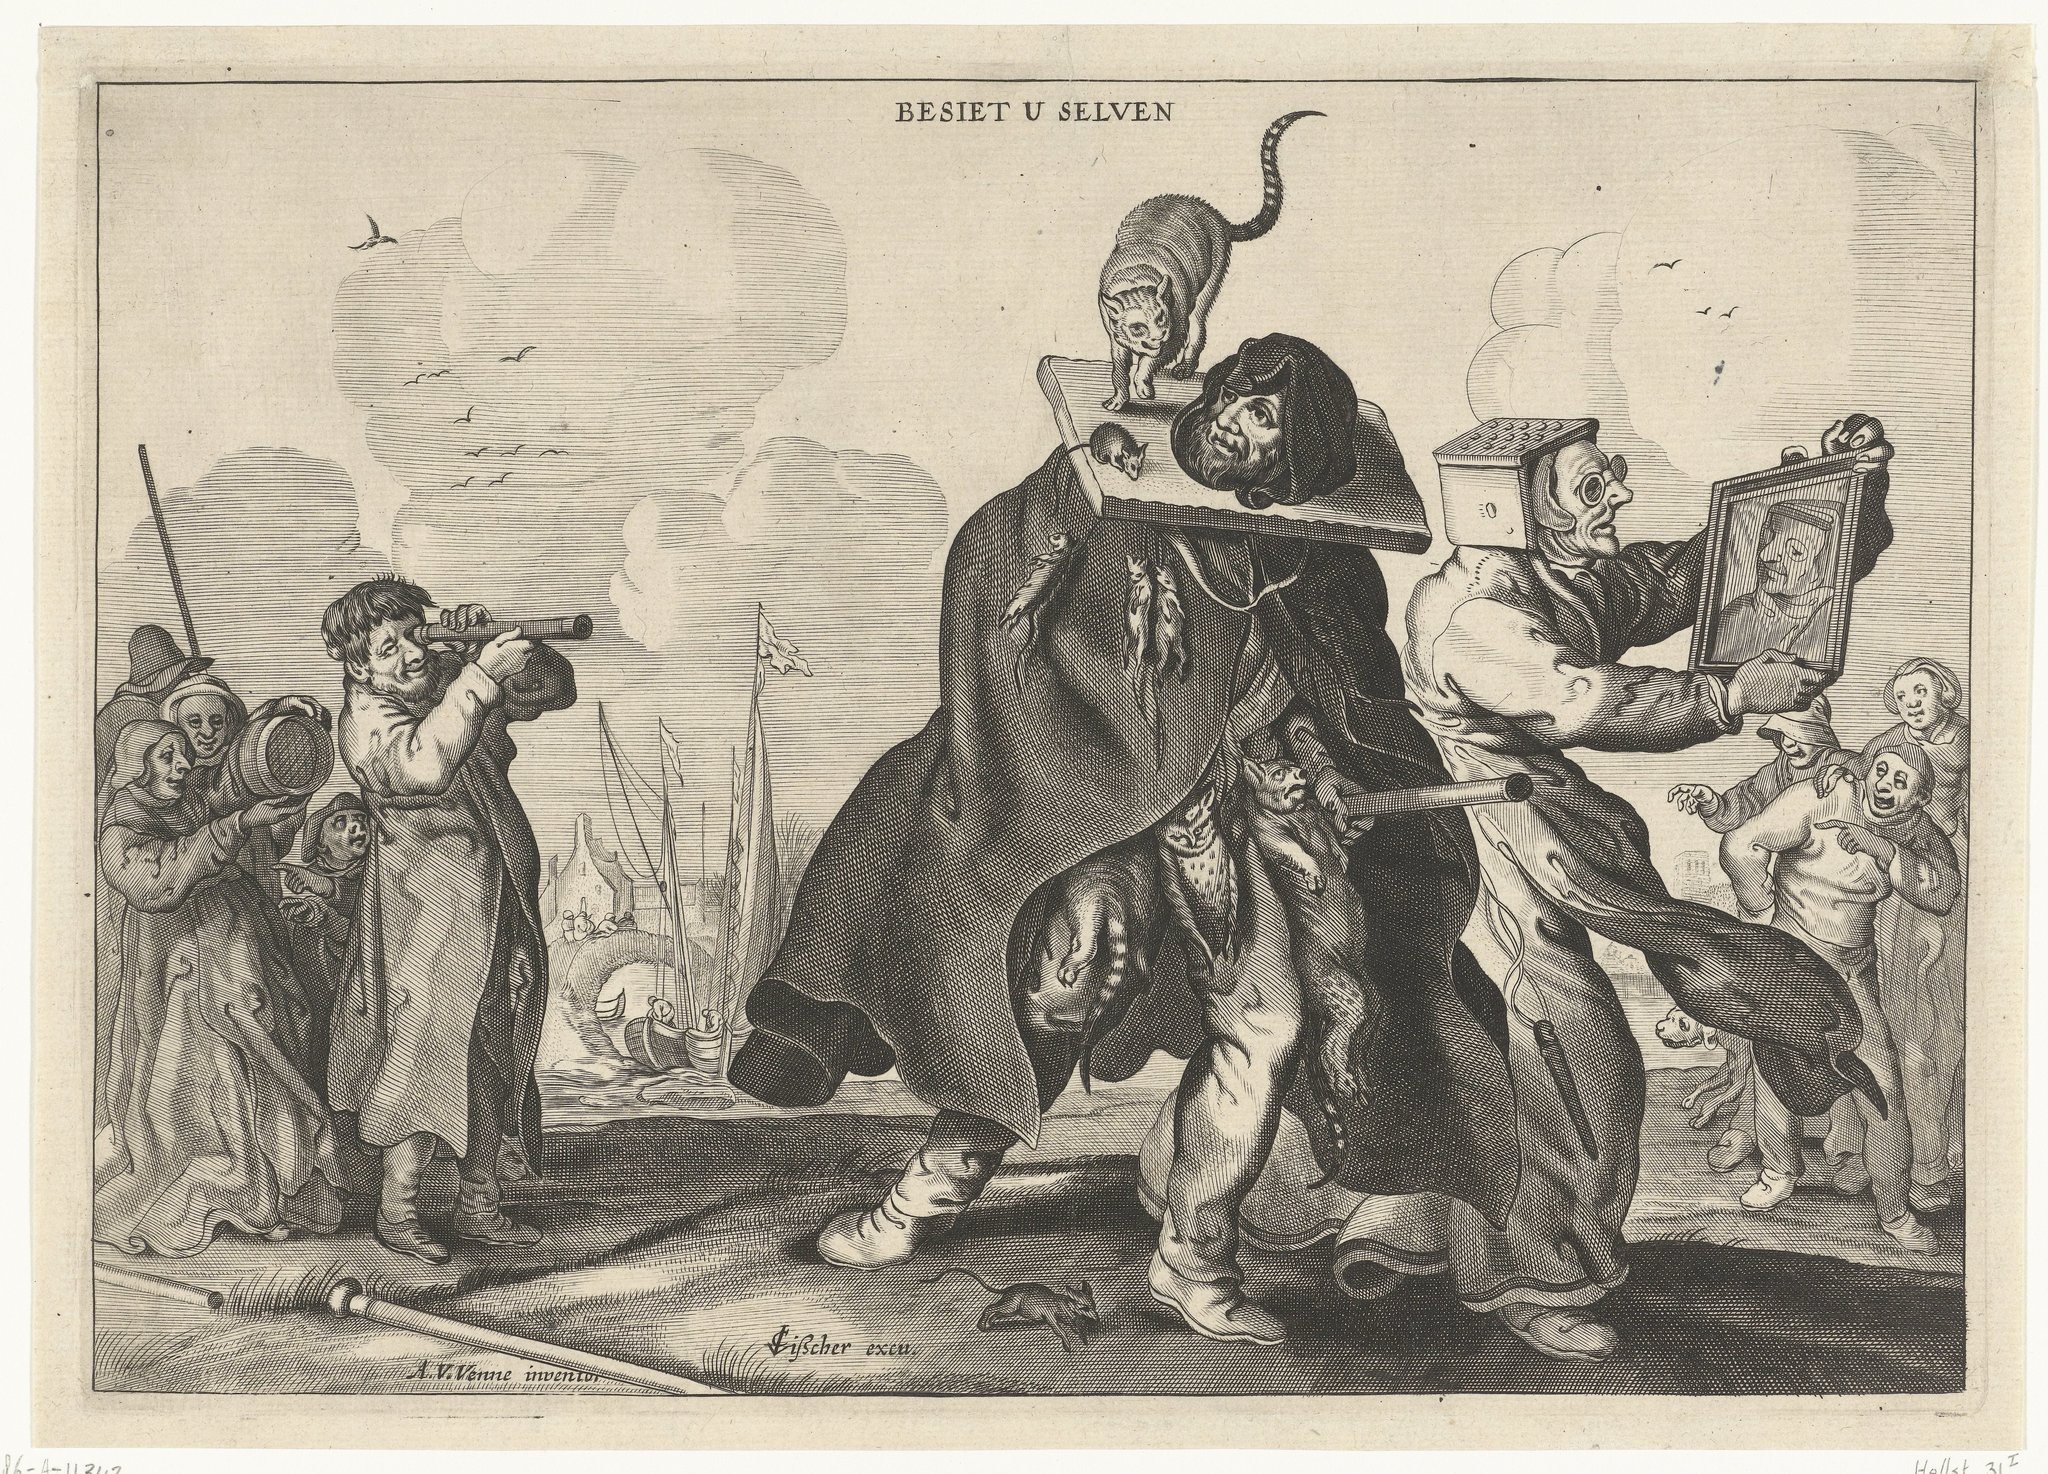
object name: print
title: Besiet u selven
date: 1612-1665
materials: paper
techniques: engraving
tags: mirror, proverbs, sayings, etc., mocking, insulting; teasing, catching animals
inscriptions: collector's mark: Lugt 2228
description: Verbeelding van het gezegde besiet u selven (kijk naar u zelf). Een man, behangen met dode katten, ratten en uilen, loopt naast vrouw met stoof op haar hoofd die zichzelf in een spiegel bekijkt. Zij zijn het middelpunt van spot en worden bekeken door een zeef en een verrekijker.